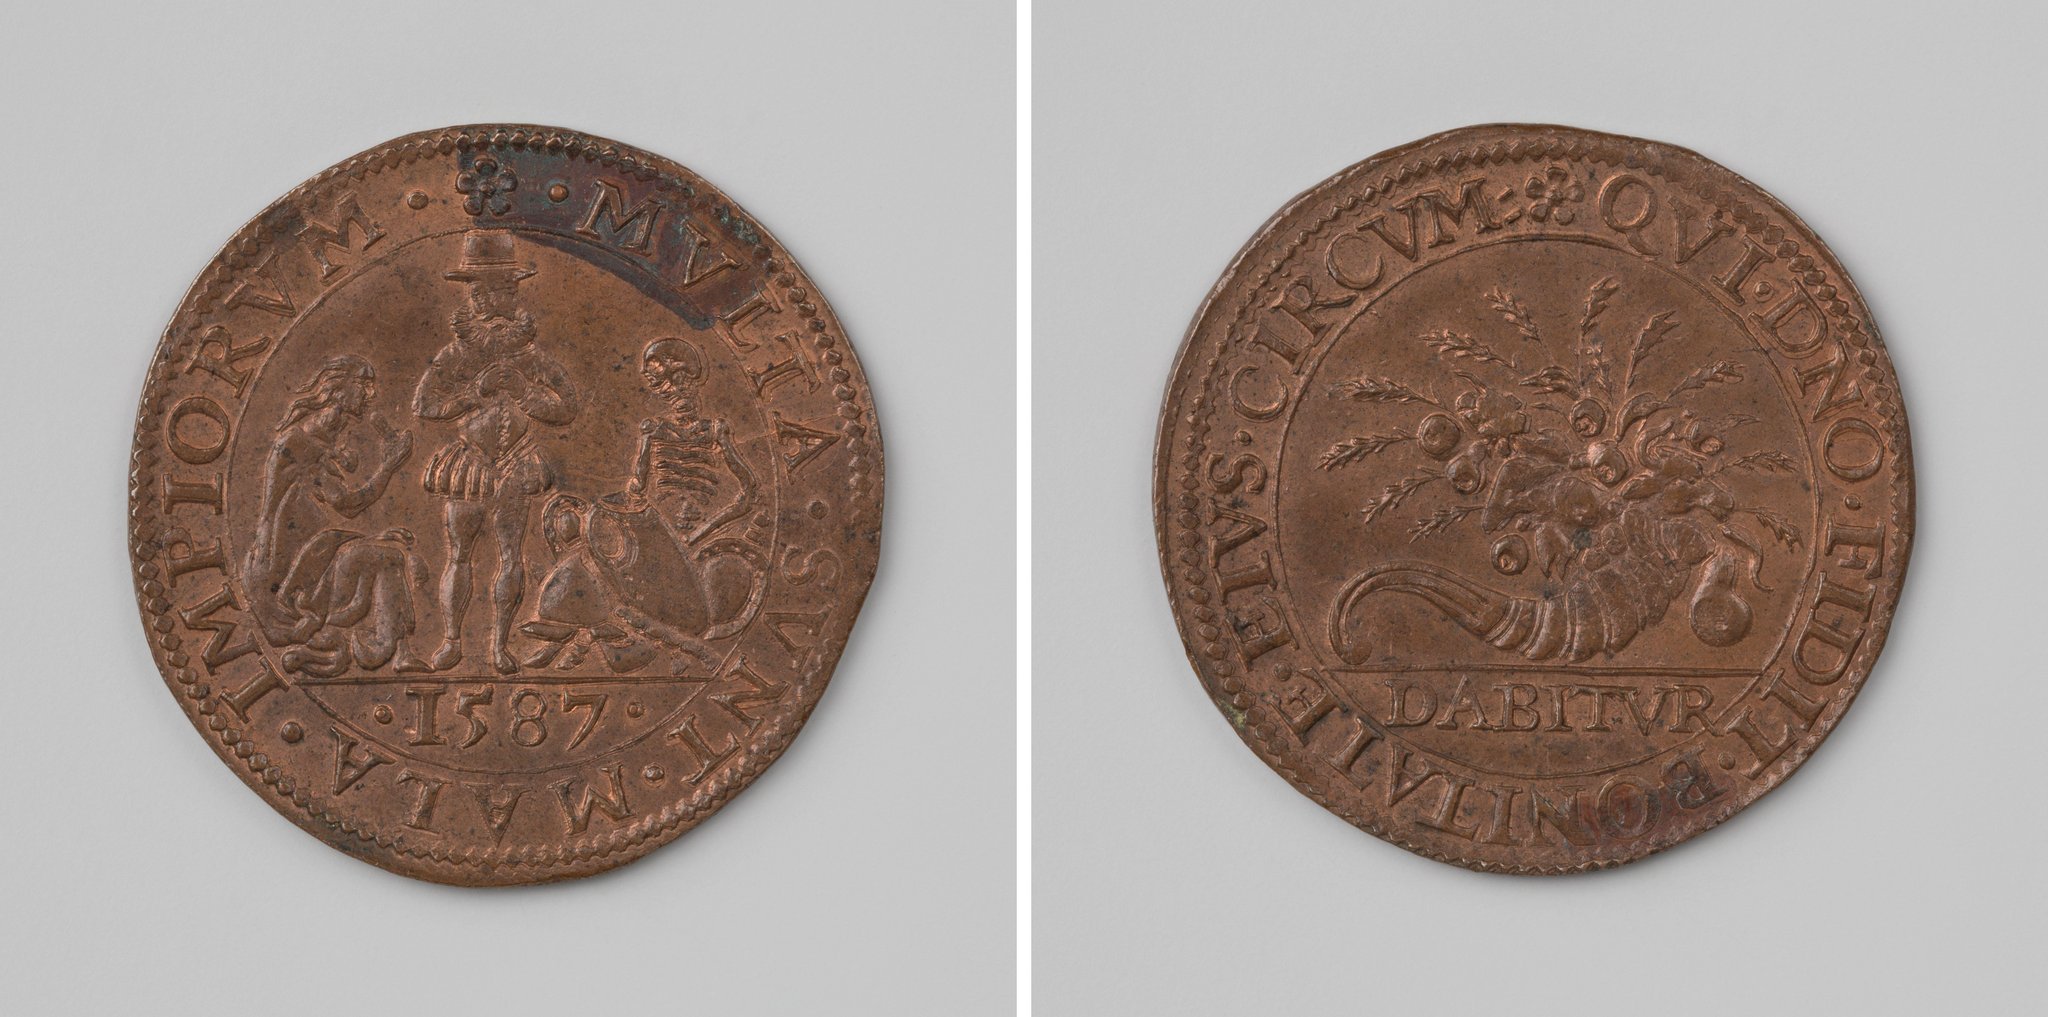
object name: jeton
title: Ziekte en hongersnood in de Spaanse Nederlanden als gevolg van de oorlogsblokkade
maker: Anonymous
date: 1587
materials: copper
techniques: striking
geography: dordrecht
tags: belgium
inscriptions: circumscription: ‘QVI DNO FIDIT BONITATE EIVS CIRCVM / DABITVR’, circumscription: ‘MVLTA SVNT MALA IMPIORVM / 1587’